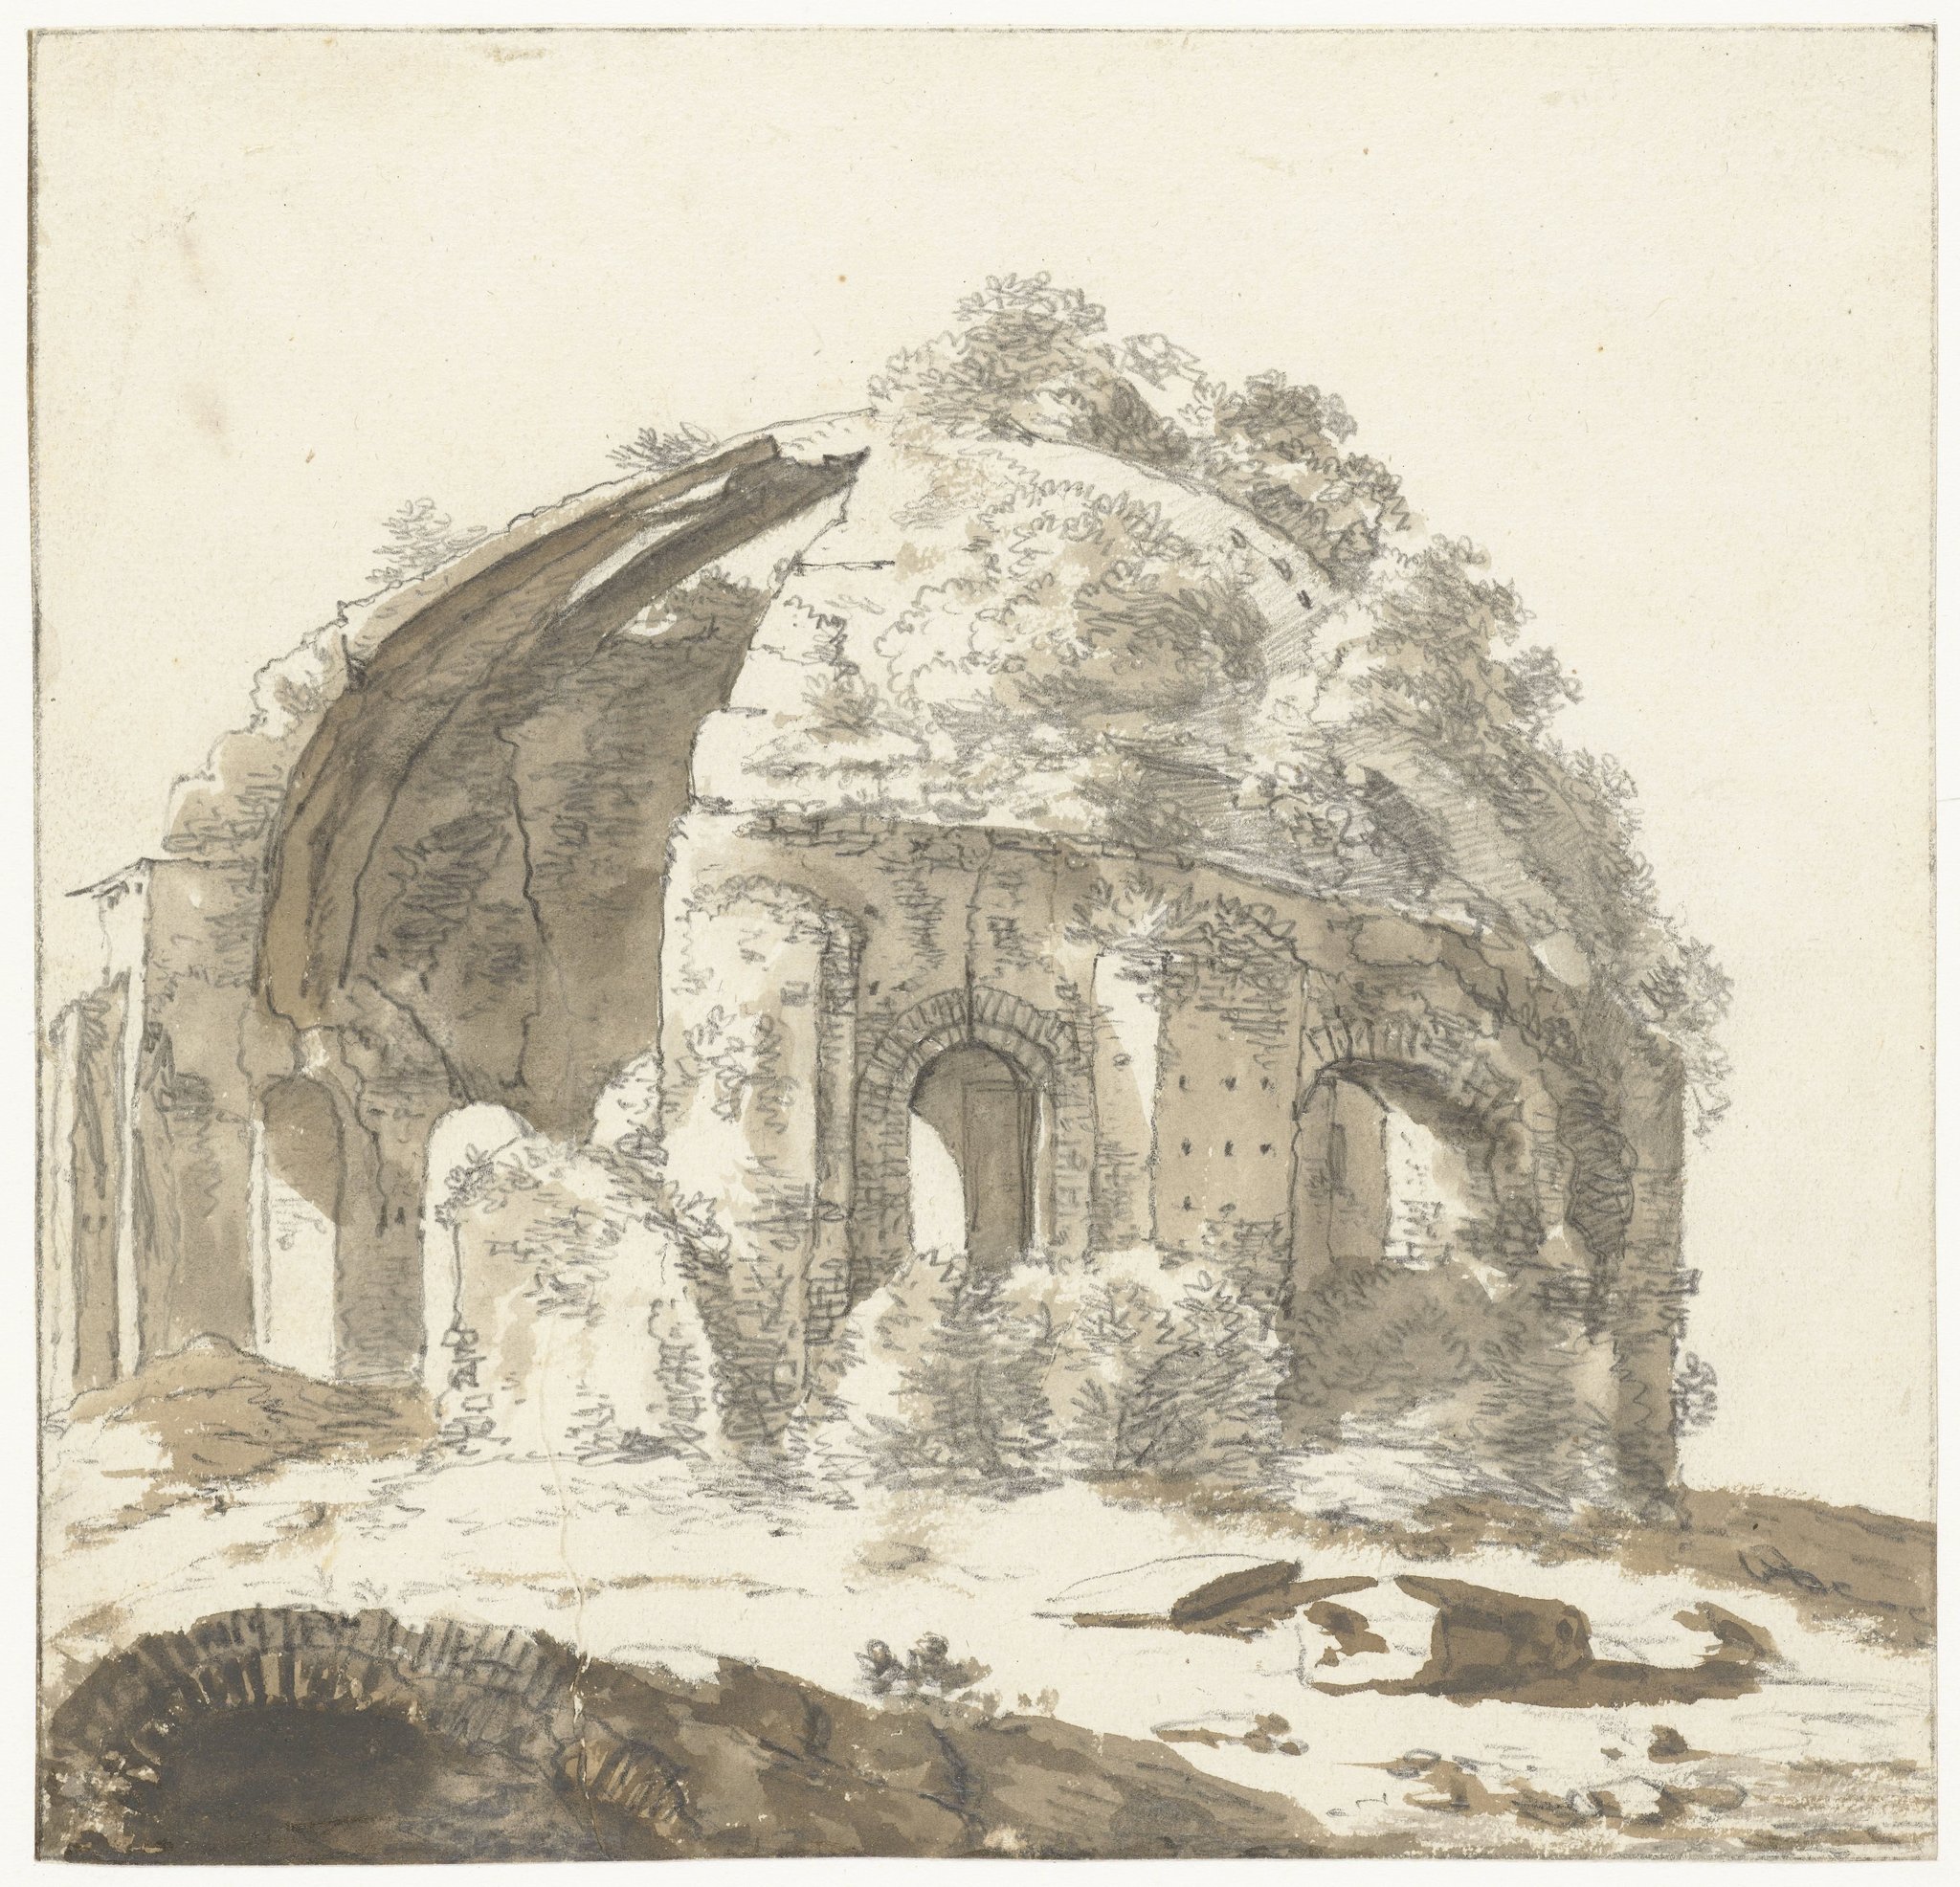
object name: drawing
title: Tempel van Minerva Medica te Rome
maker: Anonymous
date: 1600-1699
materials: paper, pencil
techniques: brush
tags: ruin of a building ~ architecture, temple, shrine ~ roman religion, rome